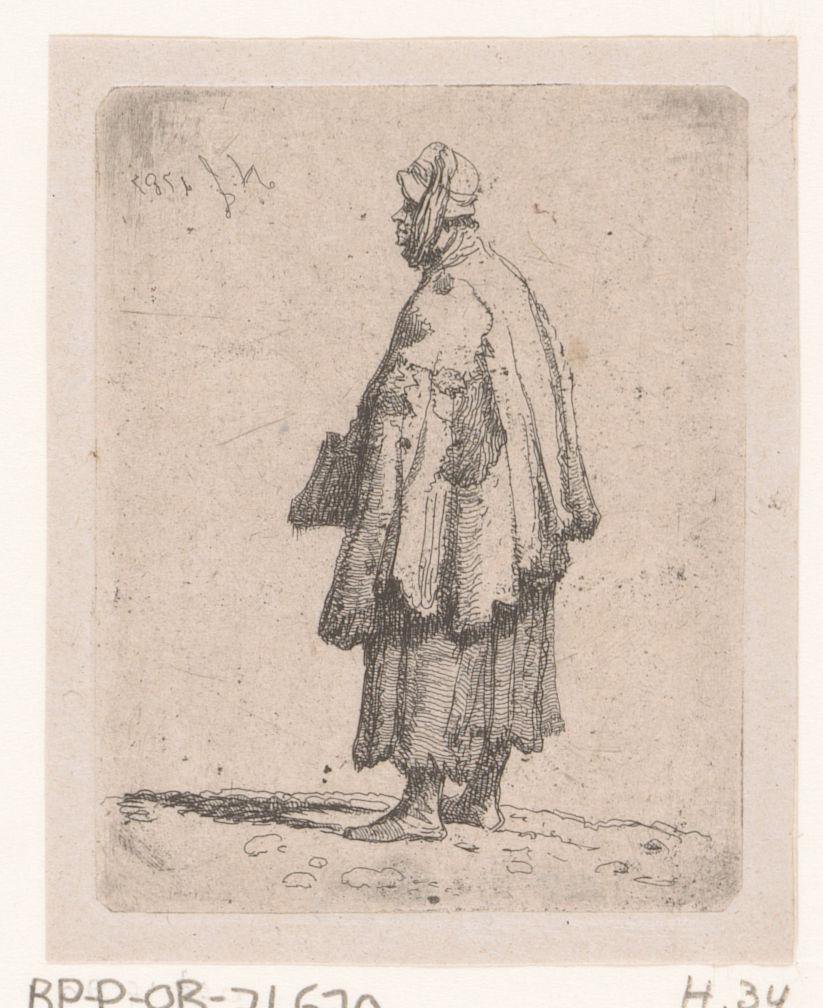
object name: print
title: Bedelares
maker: jean pierre norblin de la gourdaine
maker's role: print maker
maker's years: 1745-1830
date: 1787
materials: paper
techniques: etching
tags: clothed in rags, beggar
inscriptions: collector's mark: Lugt 2228